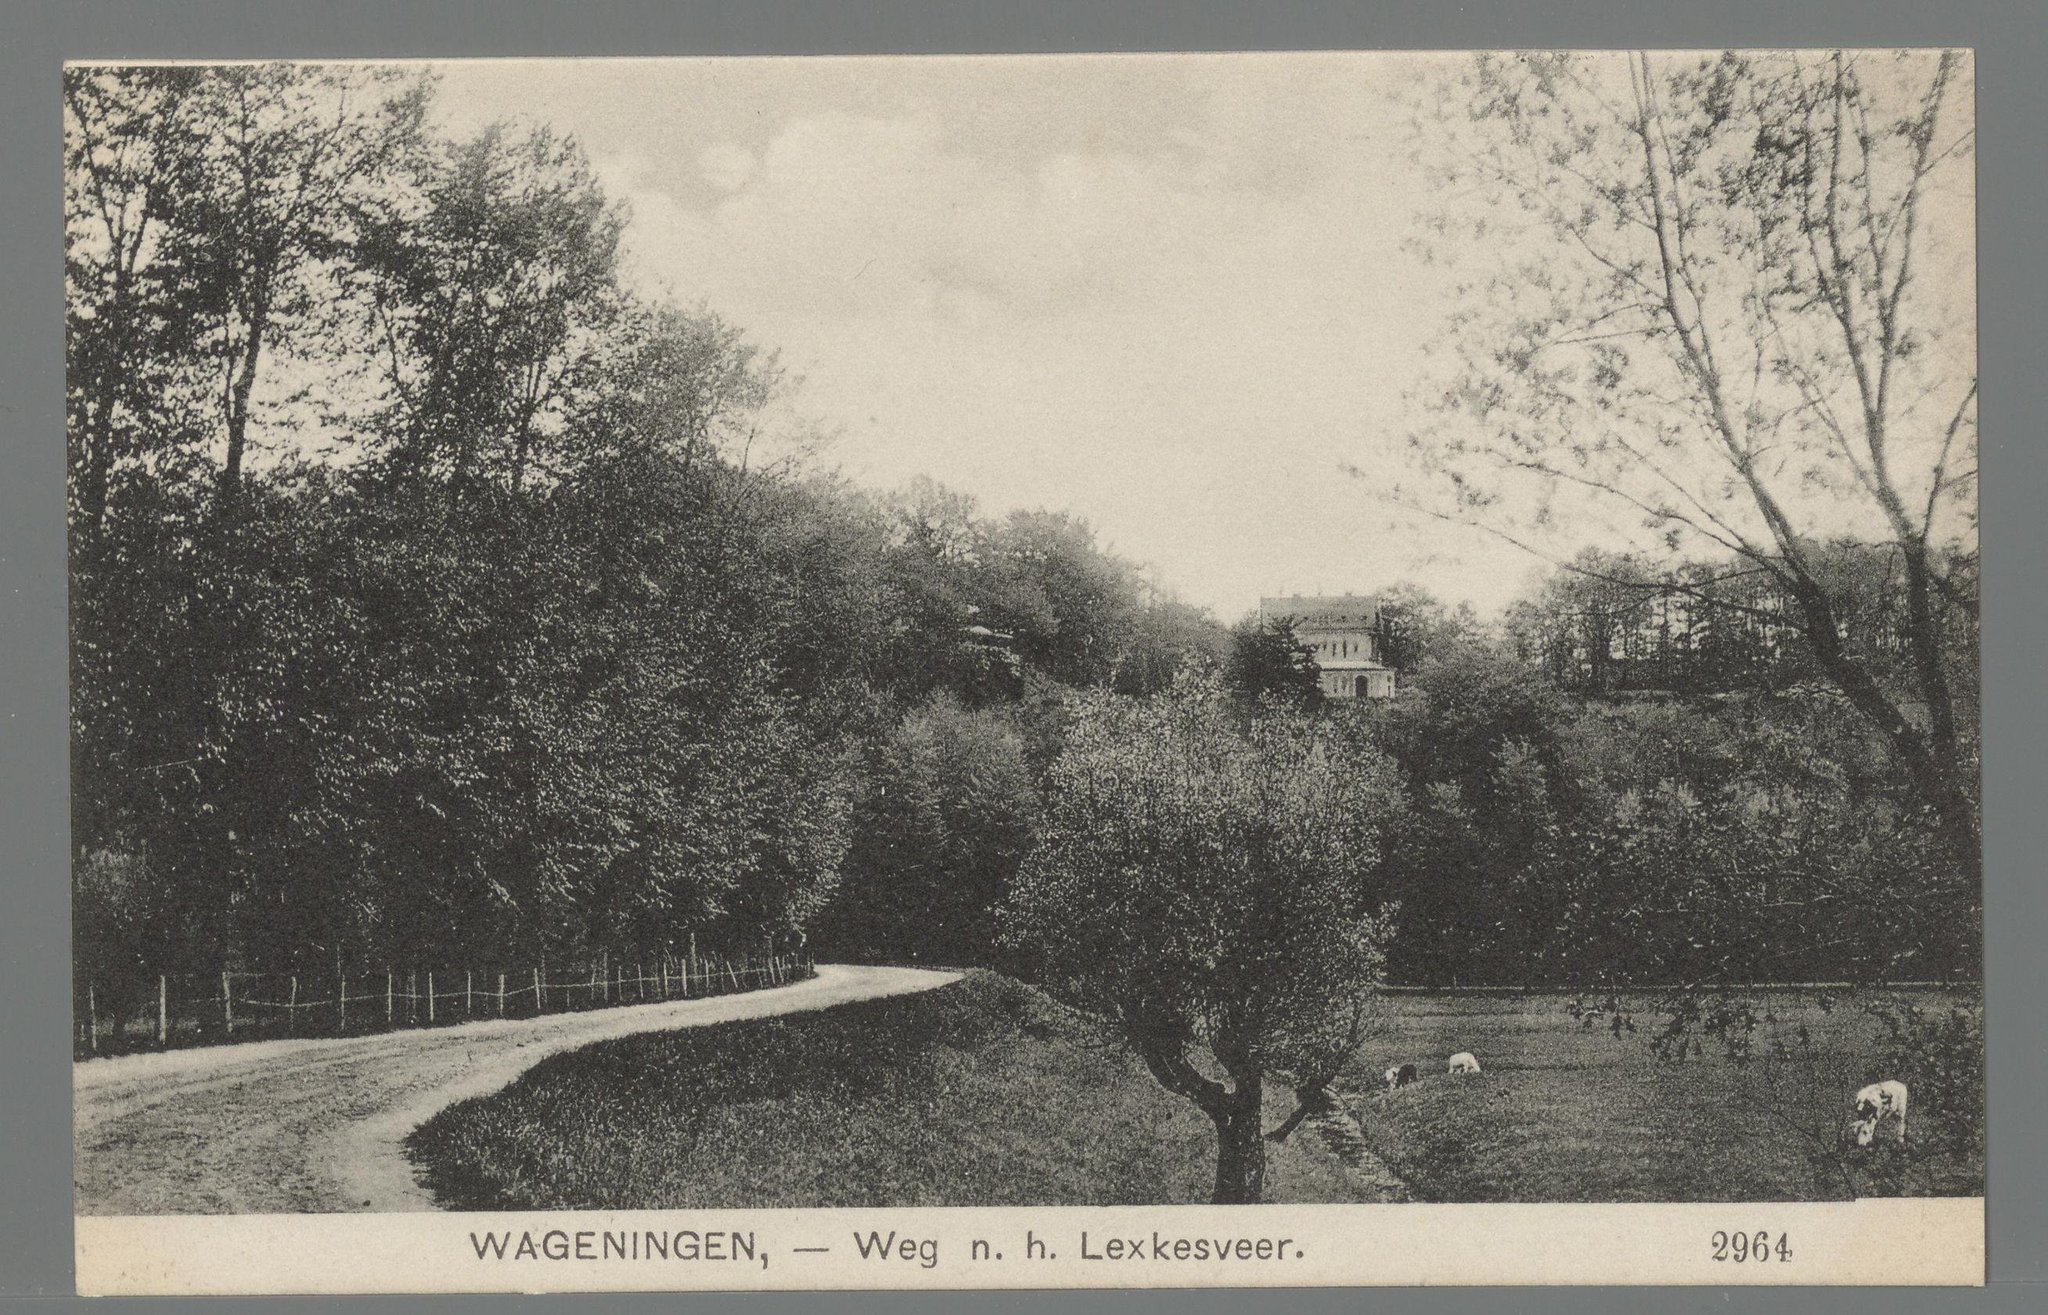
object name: ansichtkaart, prentbriefkaart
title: Wageningen, - Weg n. h. Lexkesveer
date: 1905-1927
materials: cardboard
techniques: photograph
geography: wageningen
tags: road, path